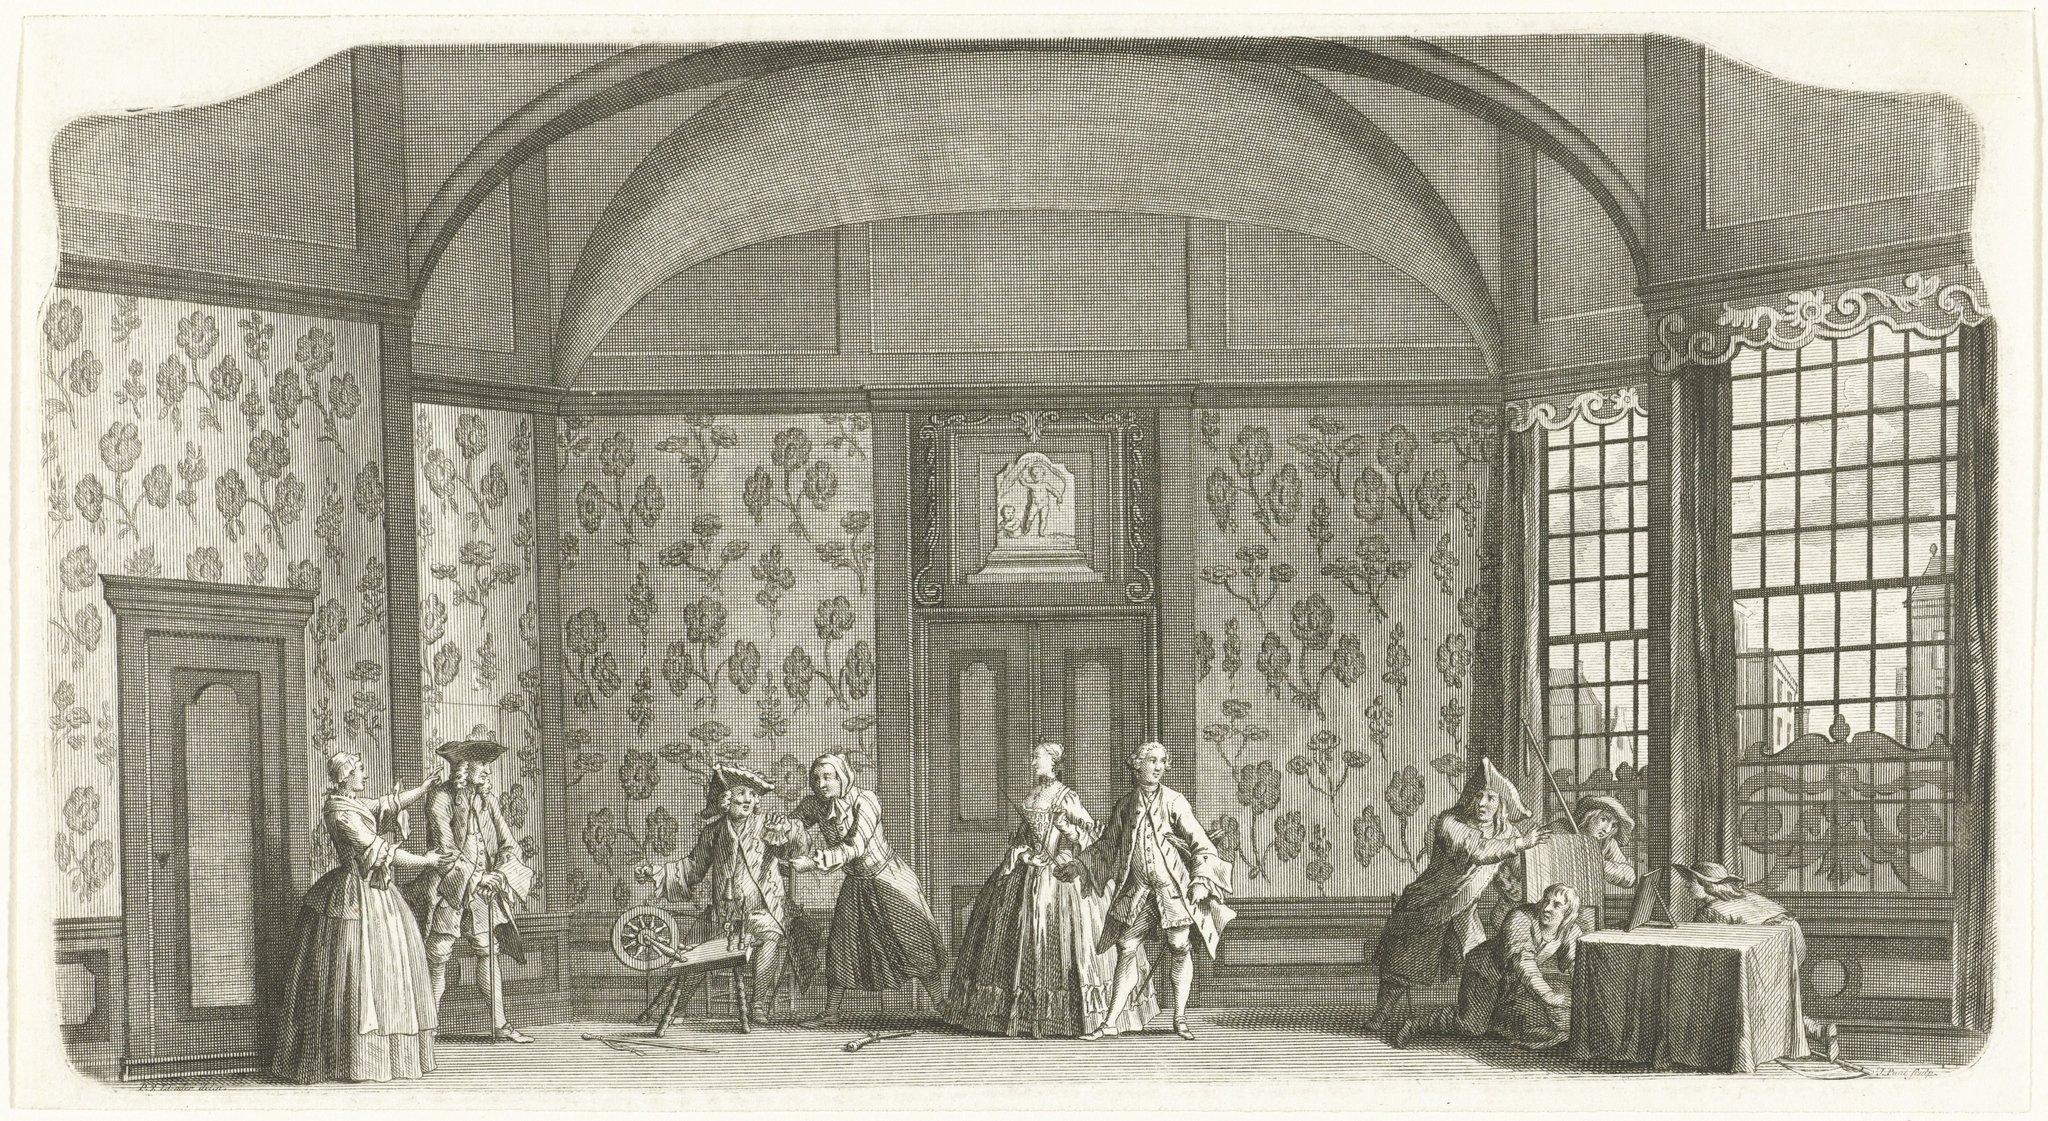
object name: print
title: Toneeldecor: De Behangen Kamer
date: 1760-1765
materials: paper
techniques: engraving, etching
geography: amsterdam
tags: theatre, theatrical performance, stage design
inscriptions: collector's mark: Lugt 2228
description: Scène uit het toneelstuk "De zwetser, kluchtspel" door Pieter Langendijk, Amsterdam 1712. Deze platen zijn in verschillende groepen in verschillende periodes vervaardigd tussen 1738-1760 en uitgegeven in verschillende series ca. 1760 en ca. 1770-1772. De platen zijn door Muller ingedeeld bij de platen van de brand van de Amsterdamse Schouwburg in 1772.